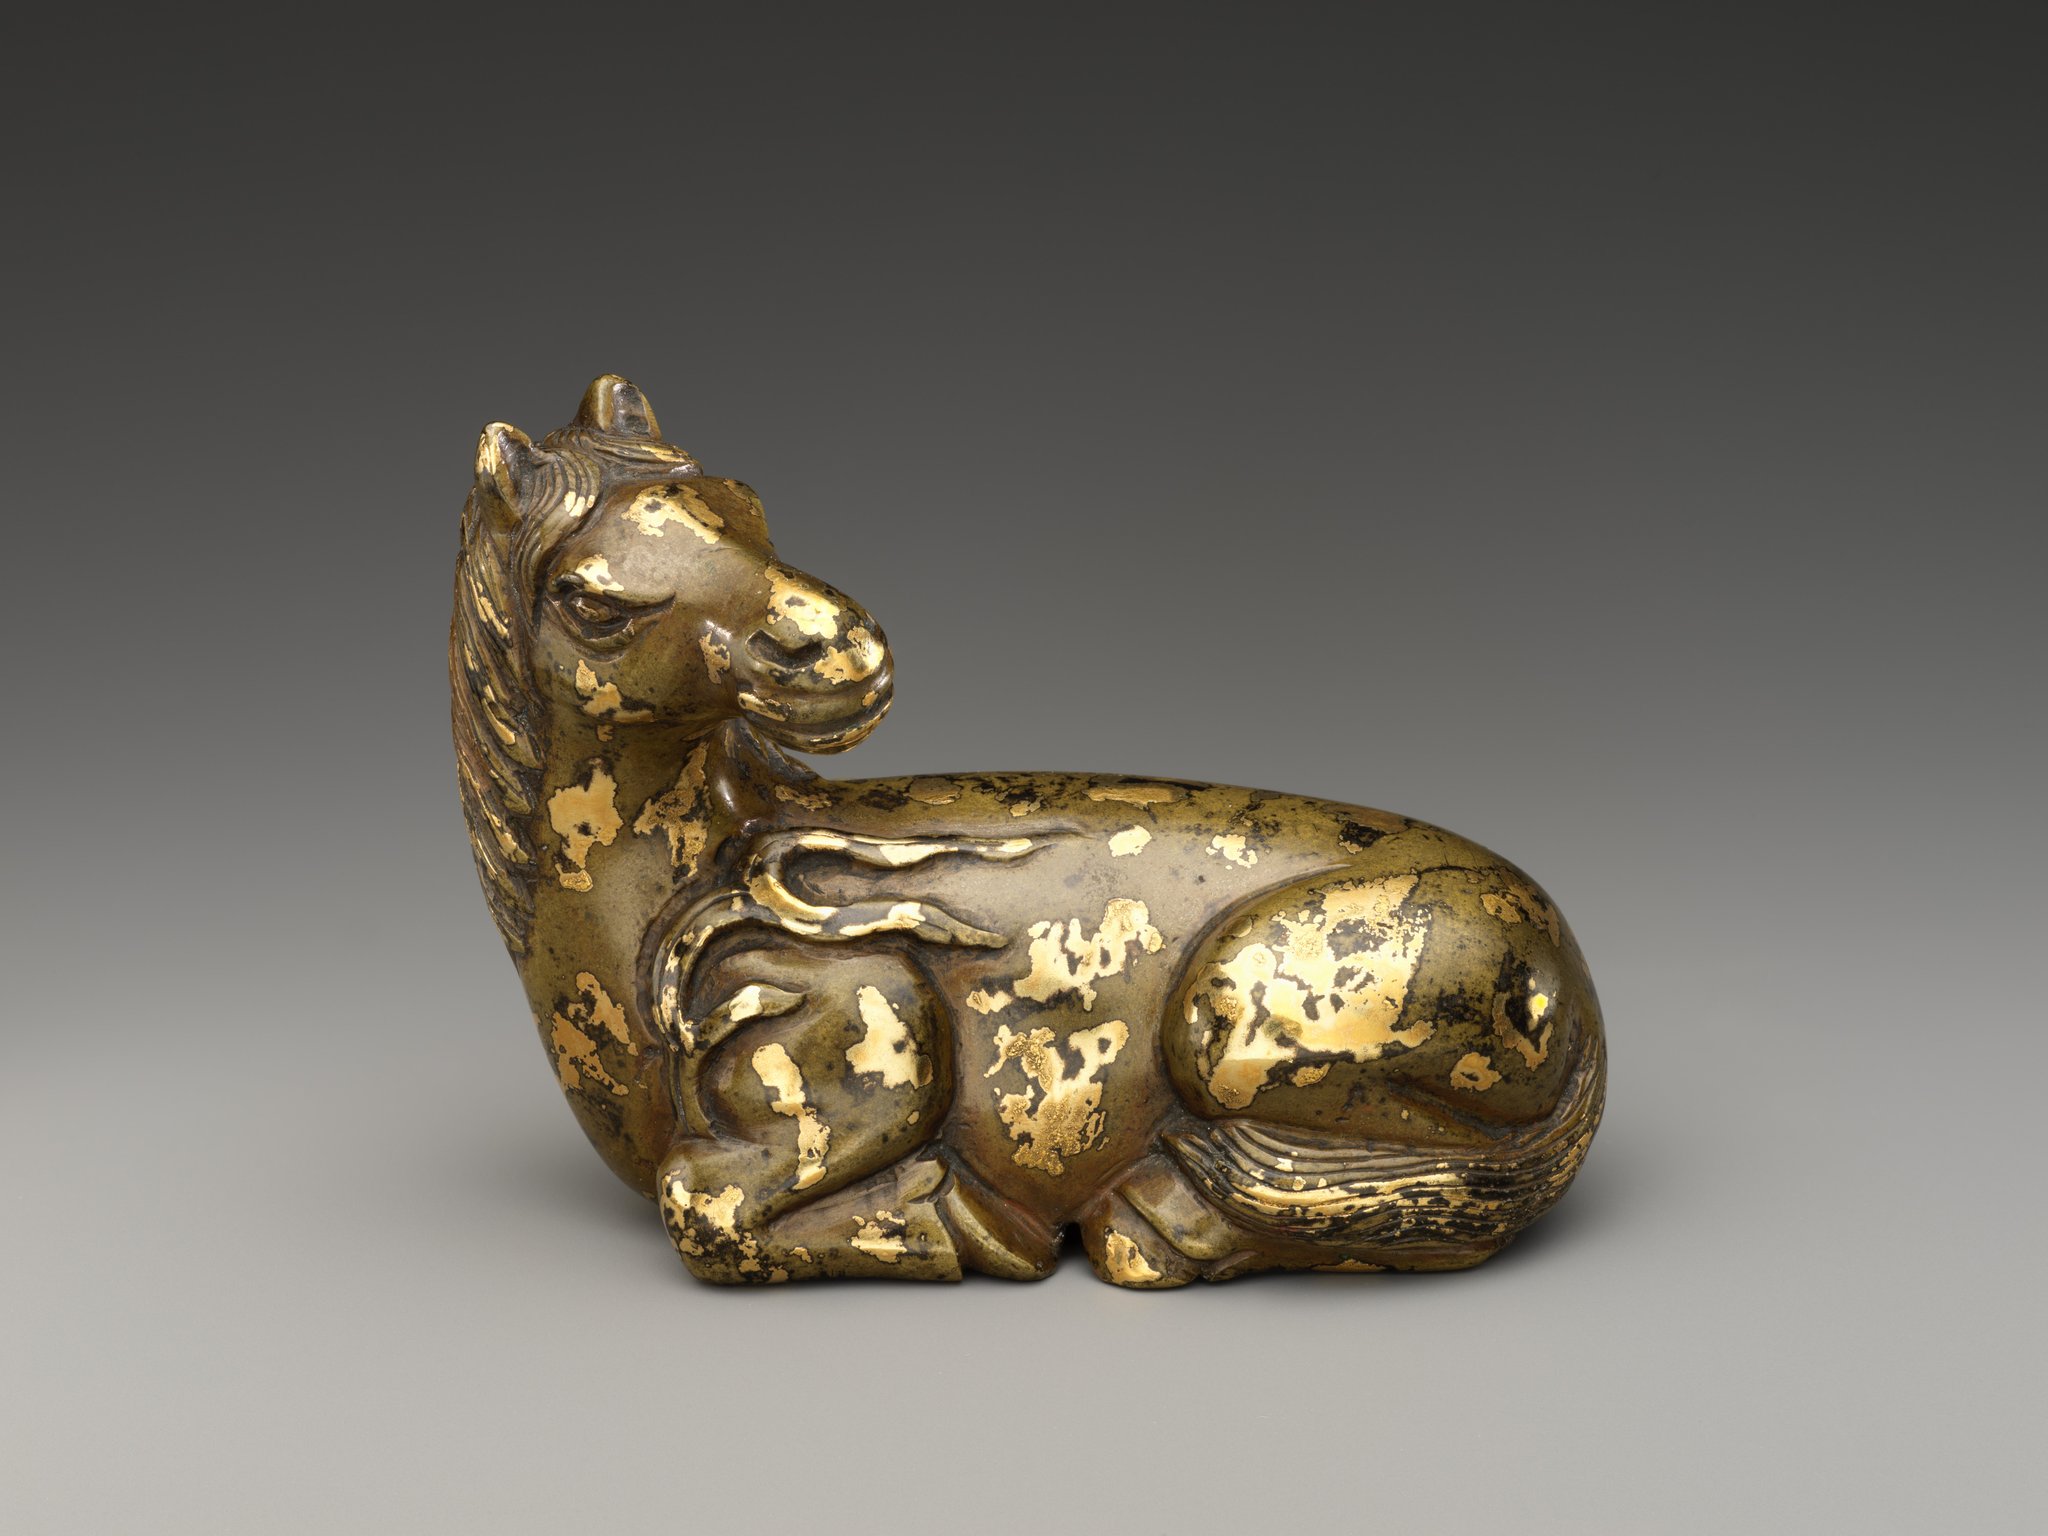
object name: figure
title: Paperweight in the shape of a horse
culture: chinese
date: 1567-1633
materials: copper alloy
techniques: gilding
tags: horses